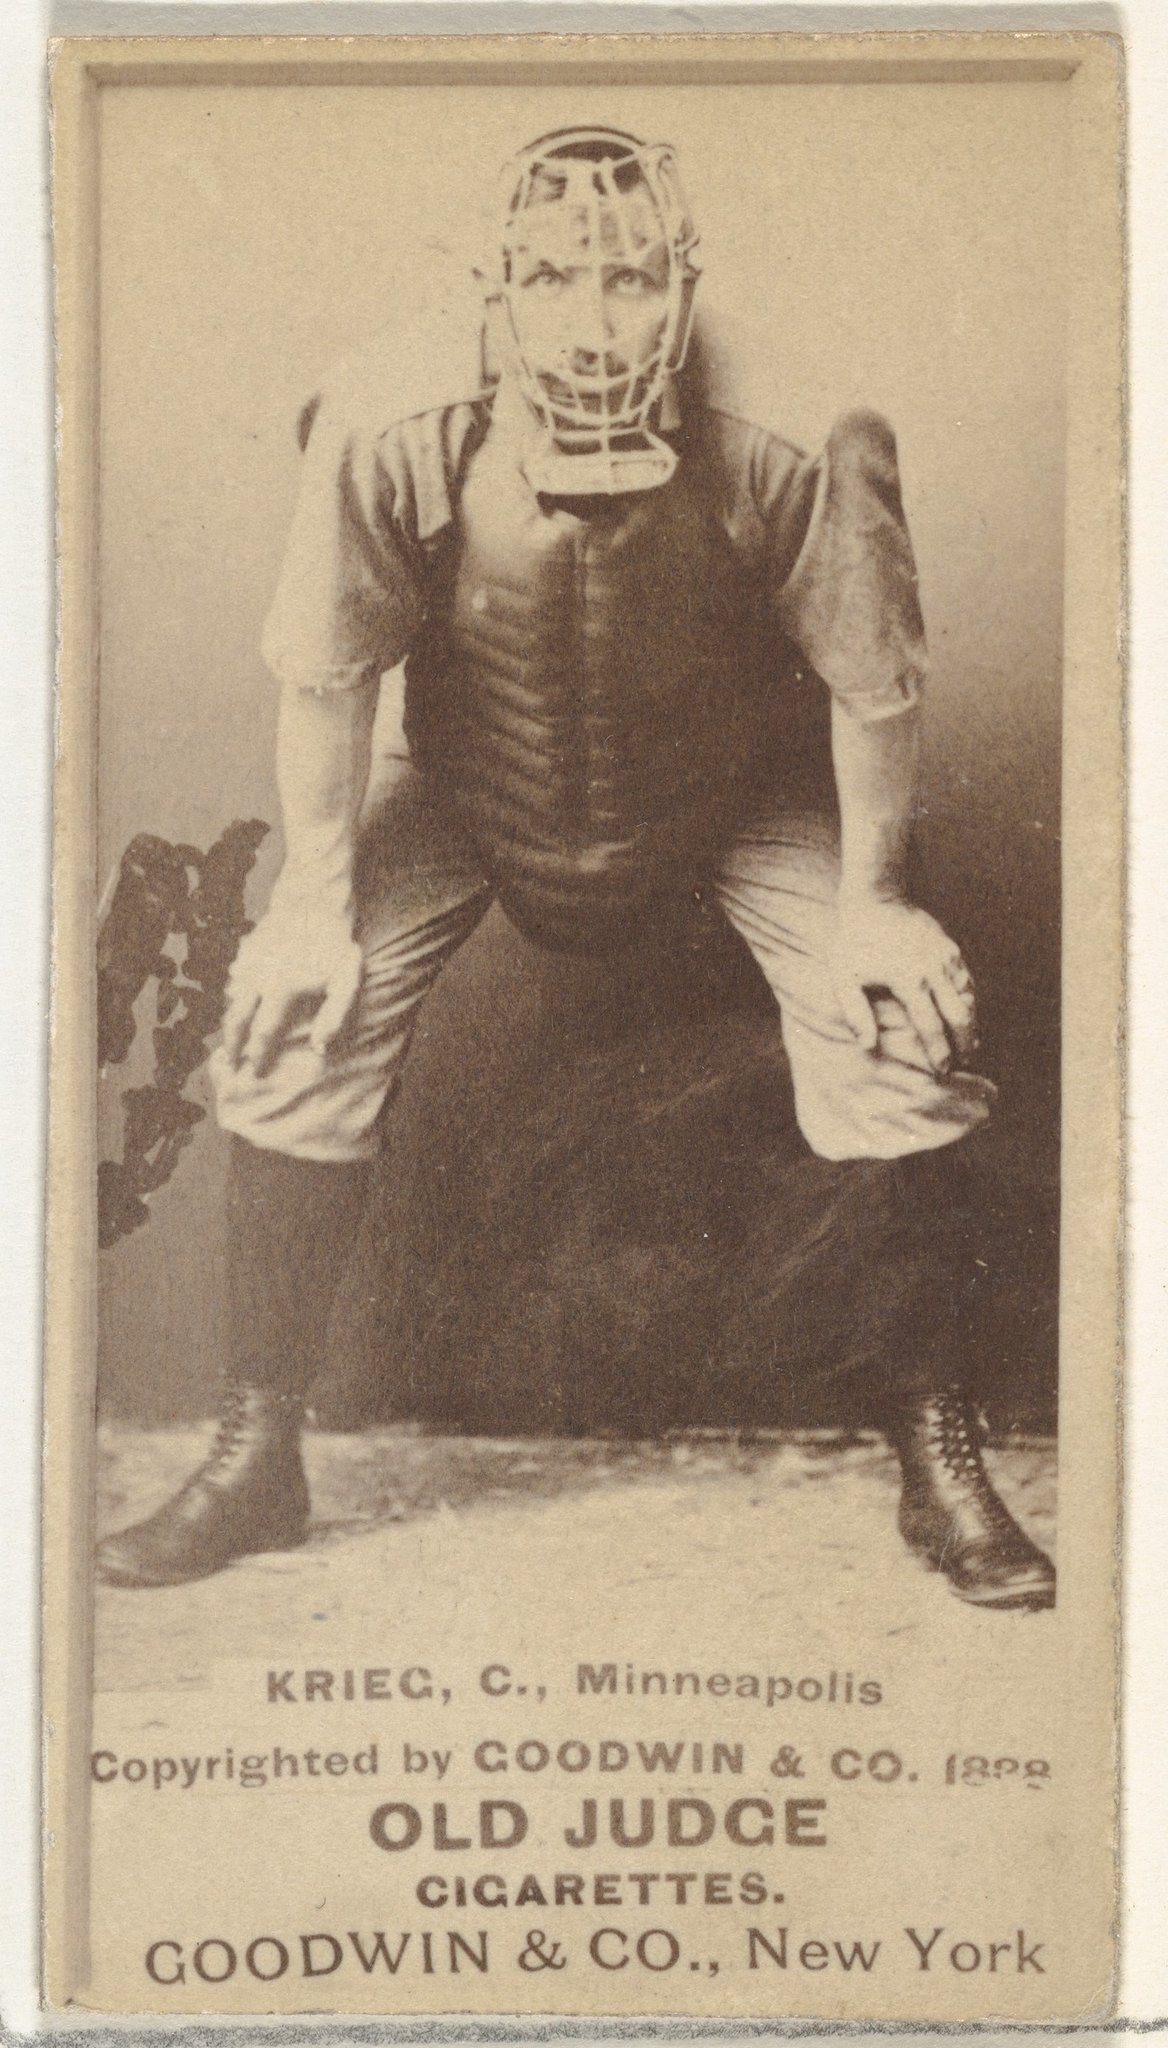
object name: baseball card, photograph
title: William Frederick "Bill" Krieg, Catcher, Minneapolis, from the Old Judge series (N172) for Old Judge Cigarettes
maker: goodwin & company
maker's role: publisher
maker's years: 1850-1950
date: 1888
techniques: albumen silver print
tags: men,portraits,baseball,athletes